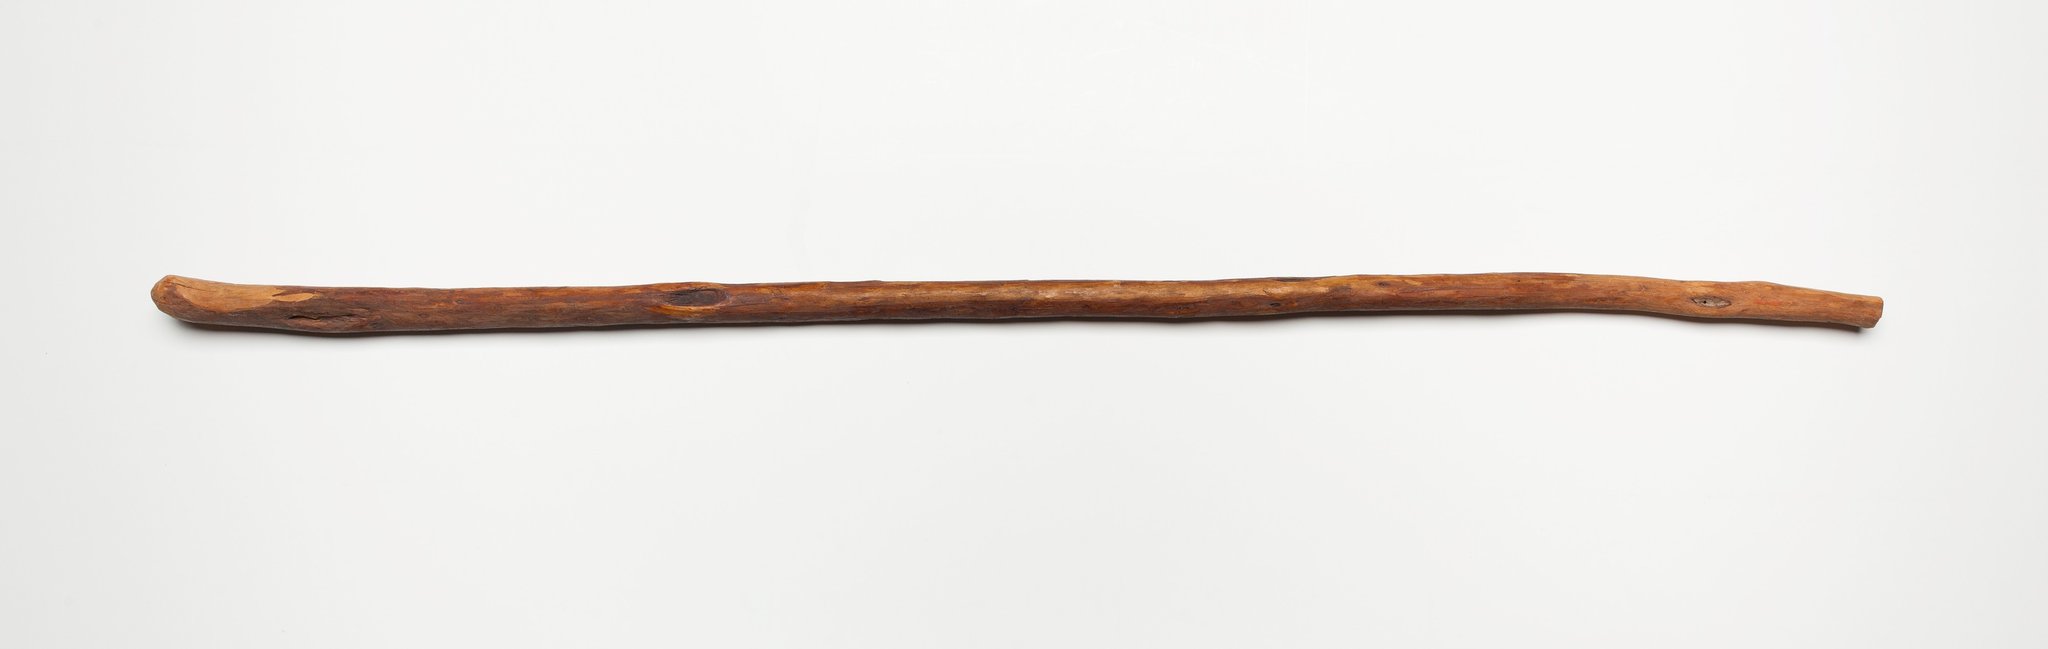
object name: staff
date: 1981-1975 BCE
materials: wood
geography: egypt